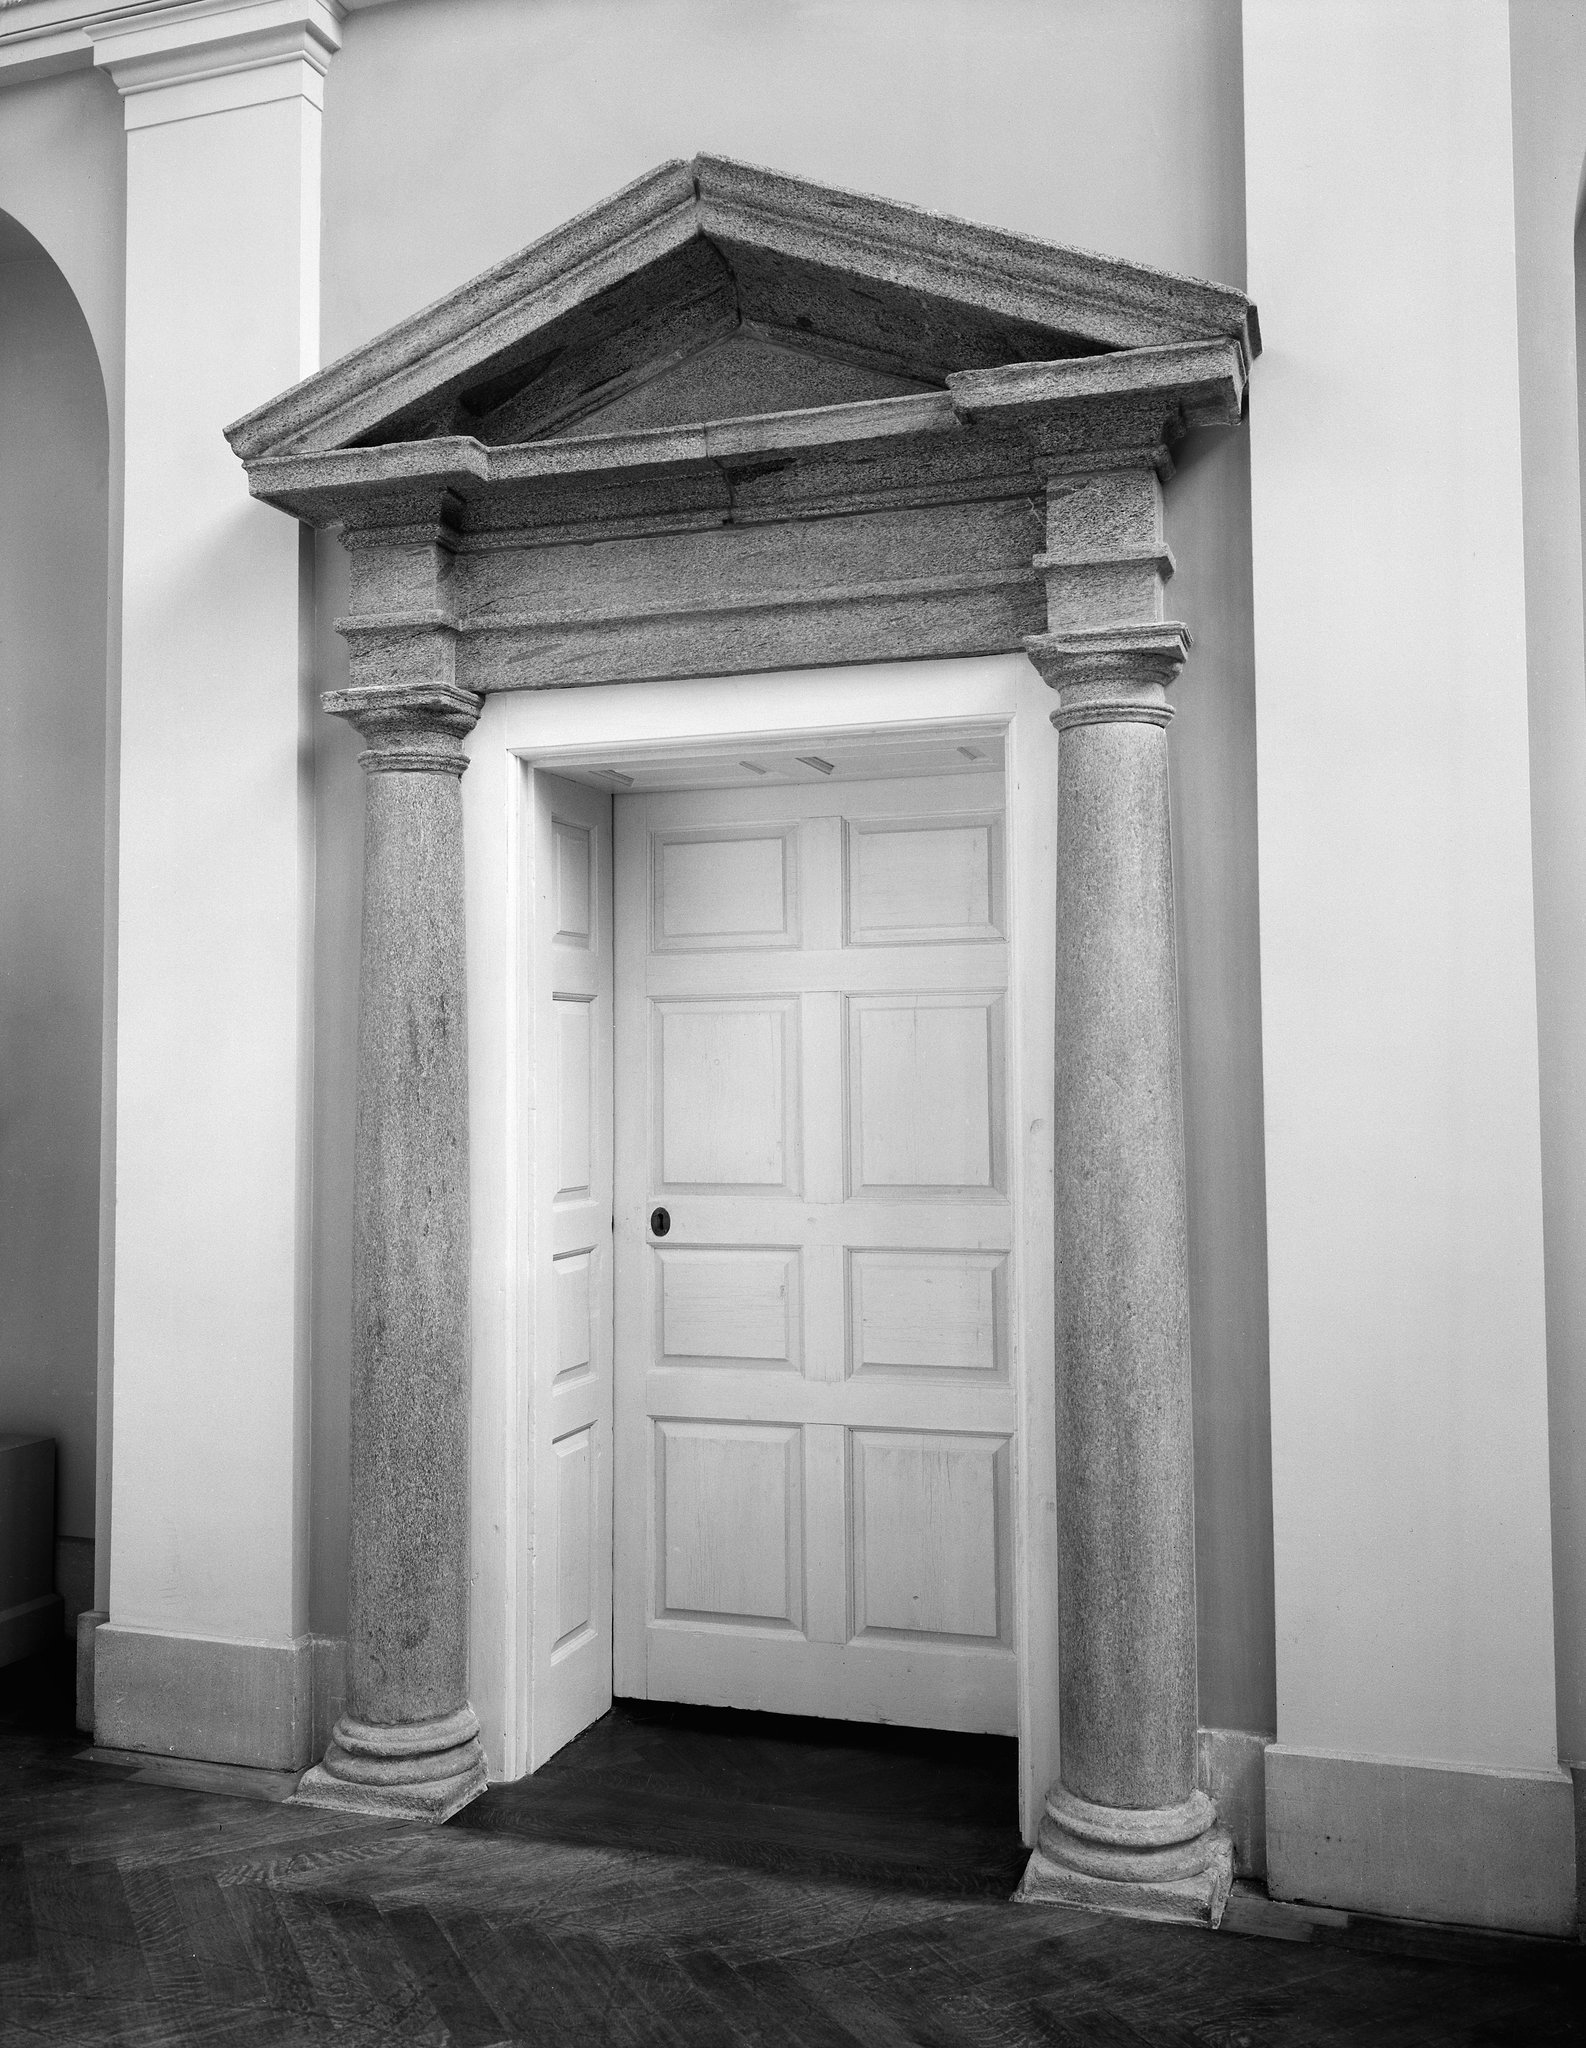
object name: doorway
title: Doorway from Chalkley Hall, Frankford, Pennsylvania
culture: american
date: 1776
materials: granite, iron, wood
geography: united states